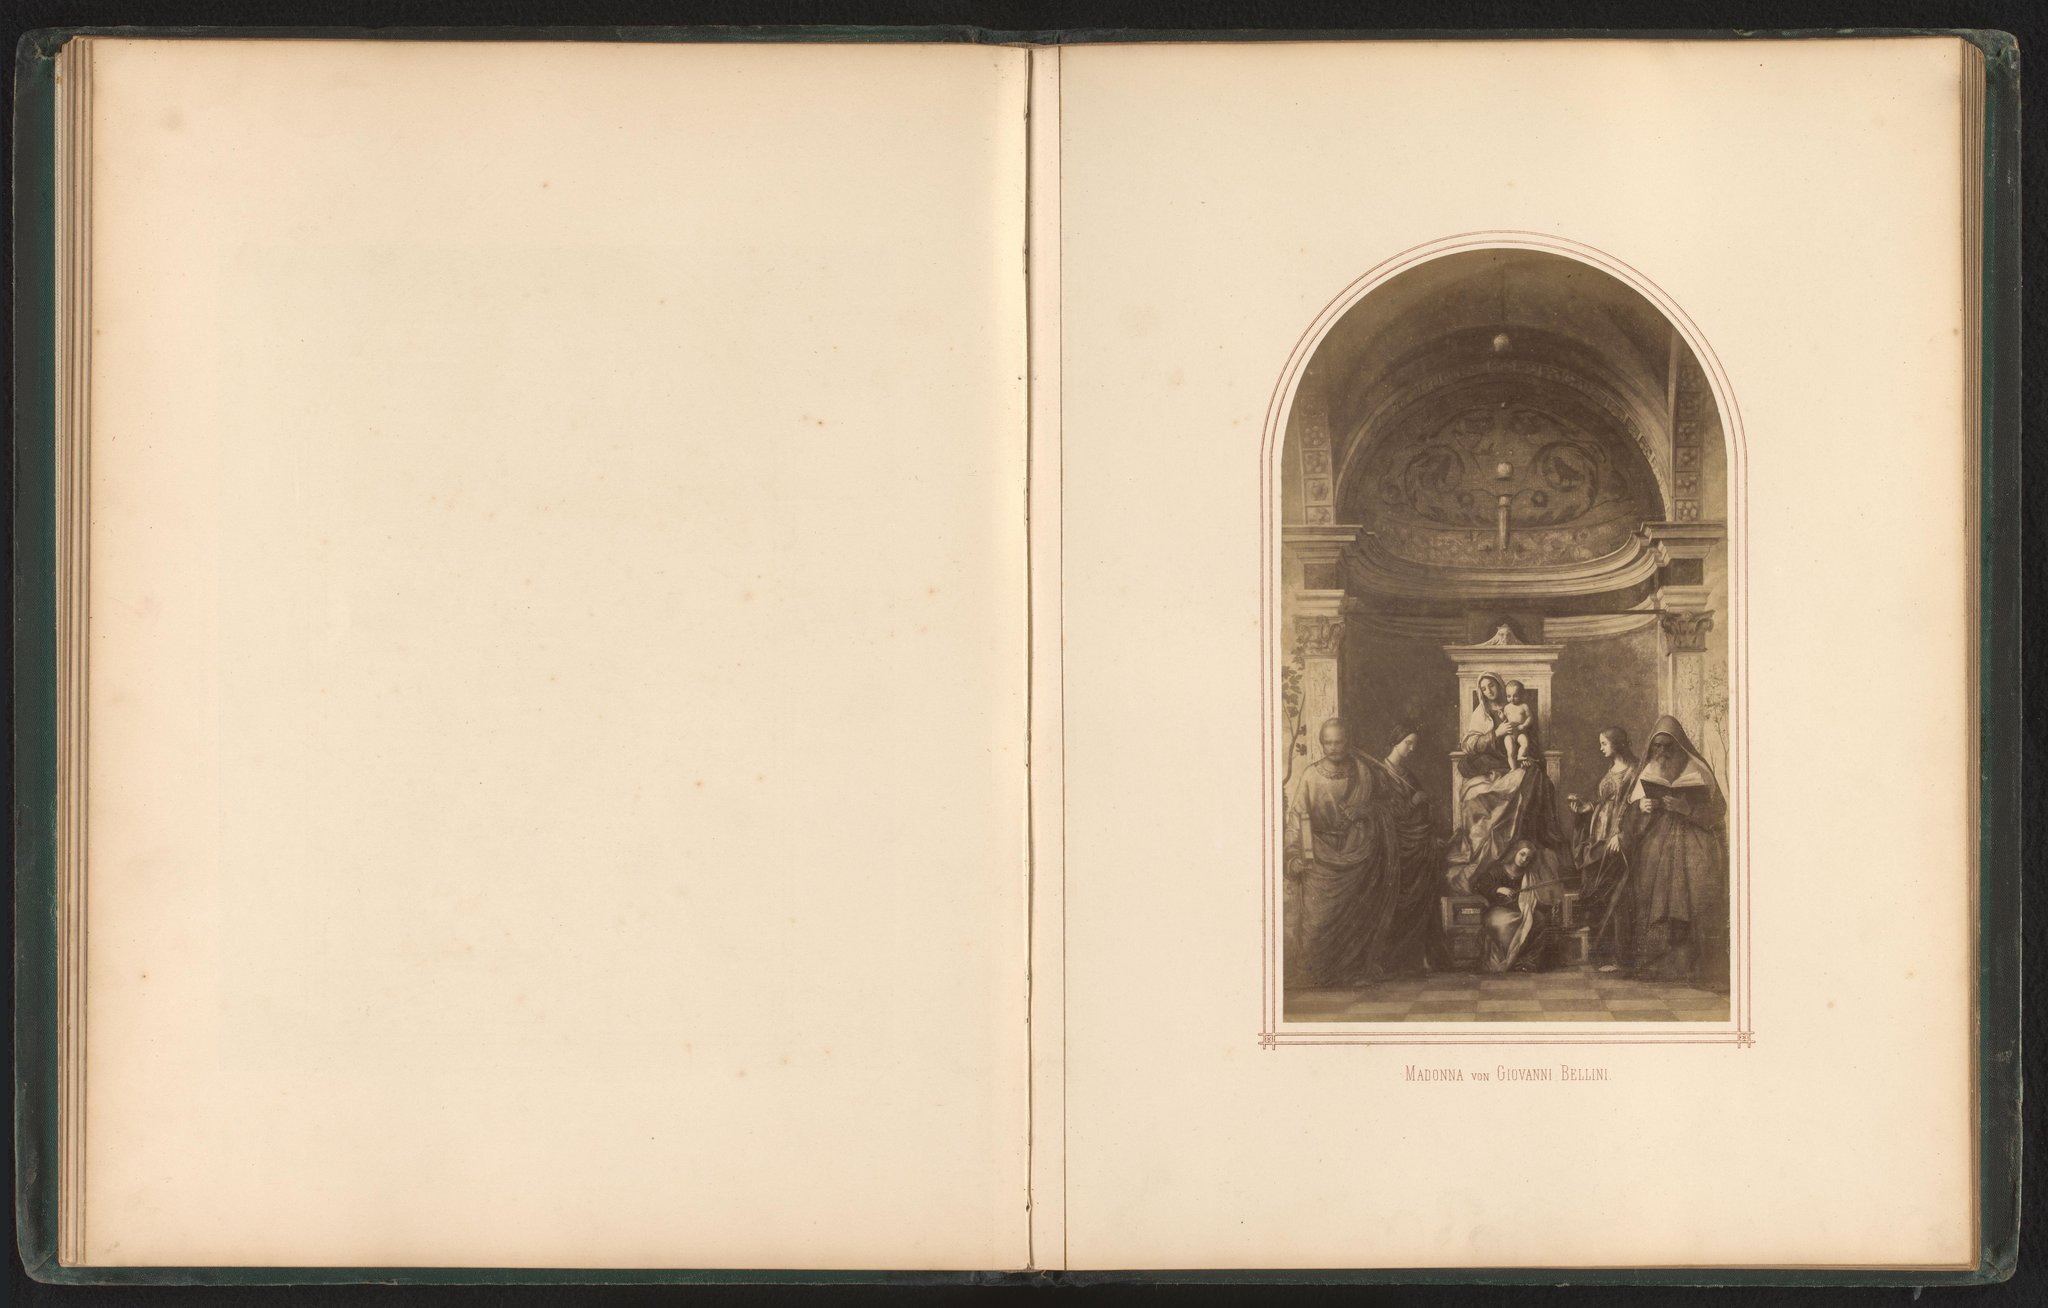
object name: page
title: Madonna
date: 1870-1875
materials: paper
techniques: albumen print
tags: madonna (i.e. mary with the christ-child) accompanied or surrounded by others, picture, painting